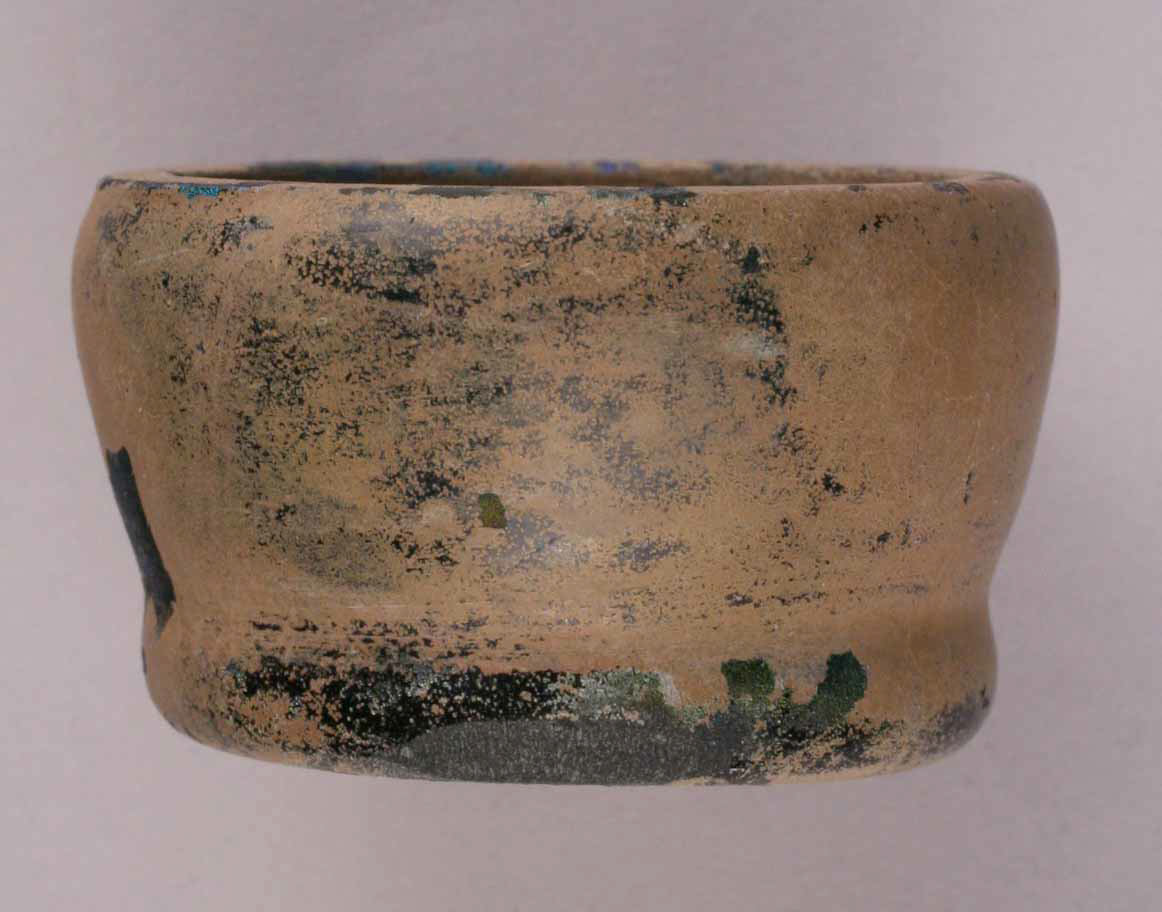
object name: bowl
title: Glass Bowl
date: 801-1000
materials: glass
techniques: glassblowing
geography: iran